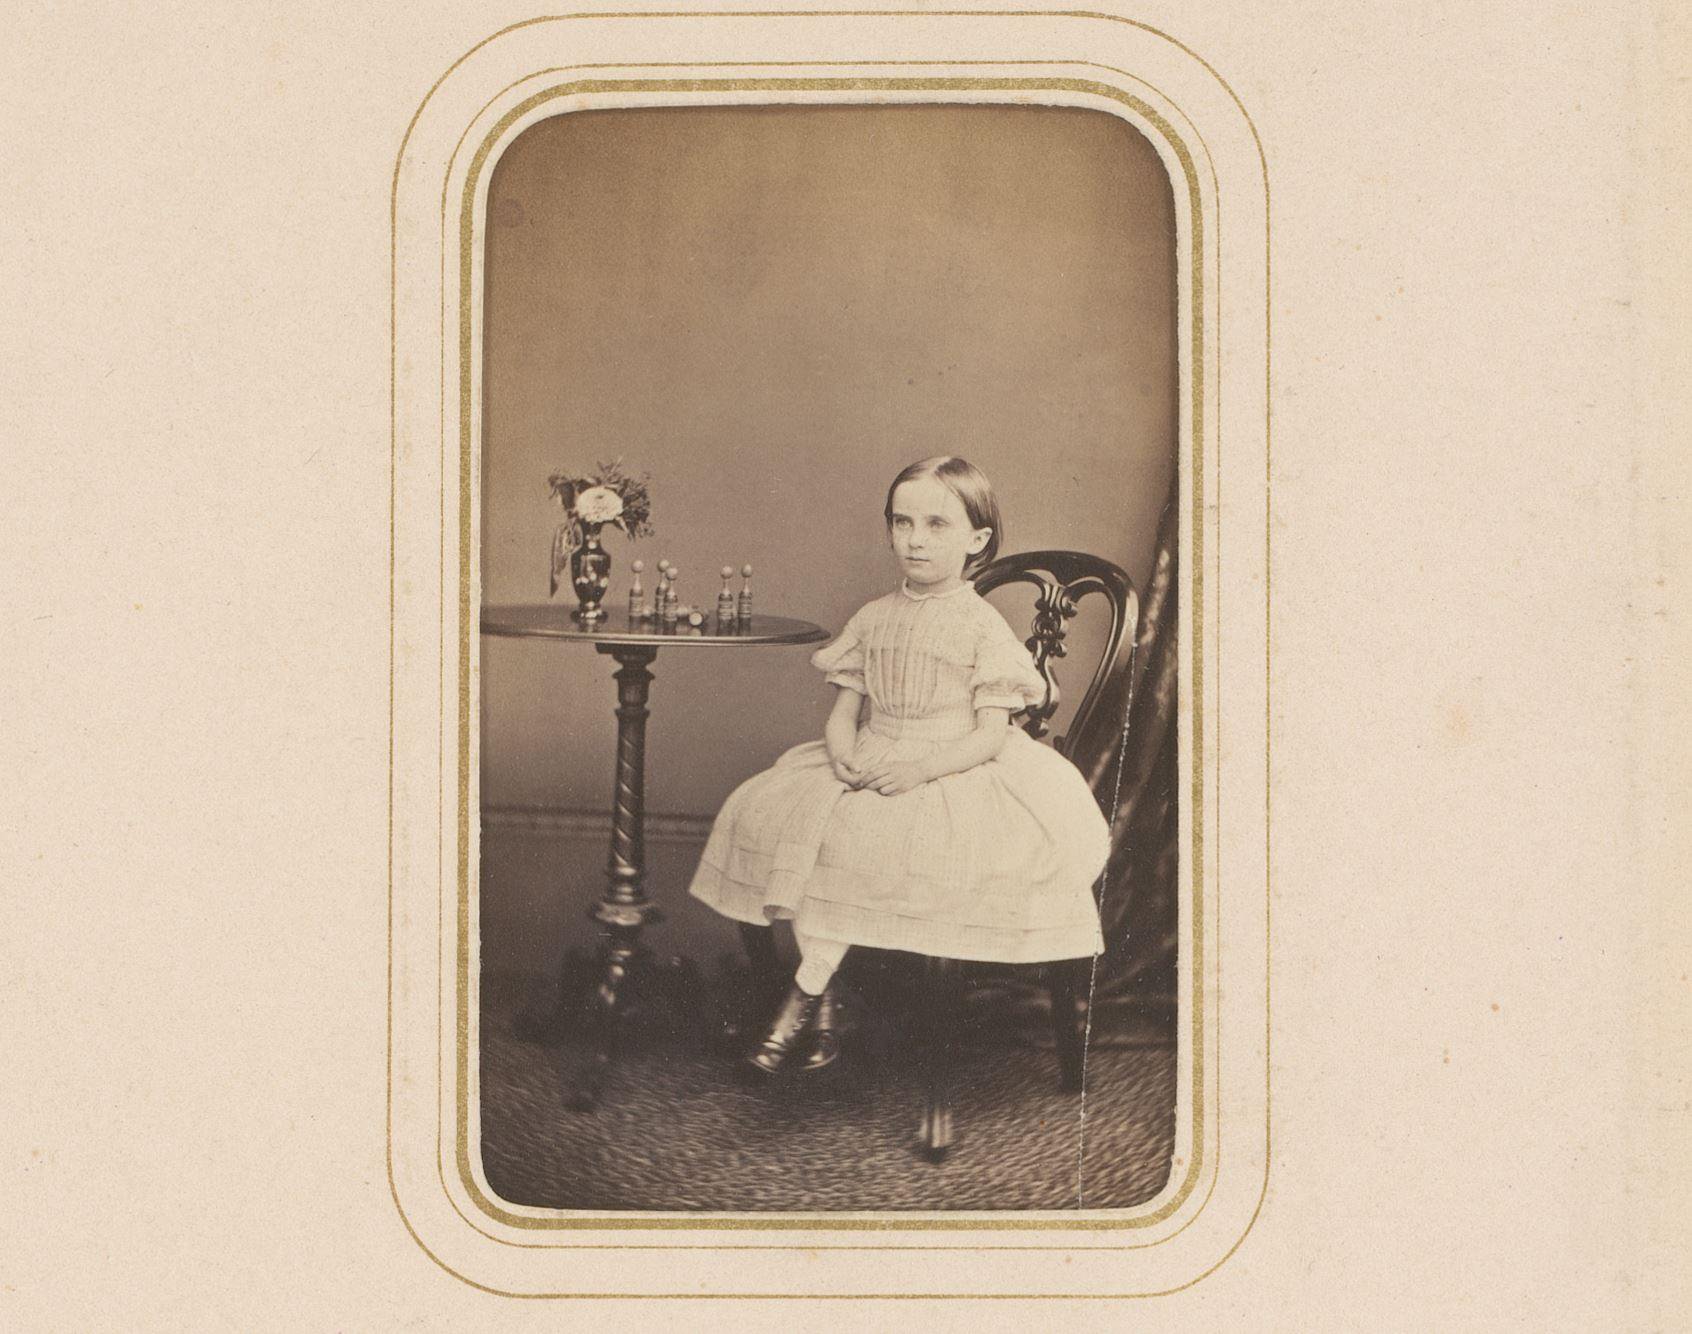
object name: photograph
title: Portret van een meisje, zittend aan een tafel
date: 1865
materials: cardboard, photographic support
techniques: albumen print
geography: london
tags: sitting figure - aa - female human figure, historical persons - bb - woman, girl (child between toddler and youth), table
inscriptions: inscription: ‘A & E SEELEY,/ ISLINGTON GREEN, N.’, date: ‘1865’